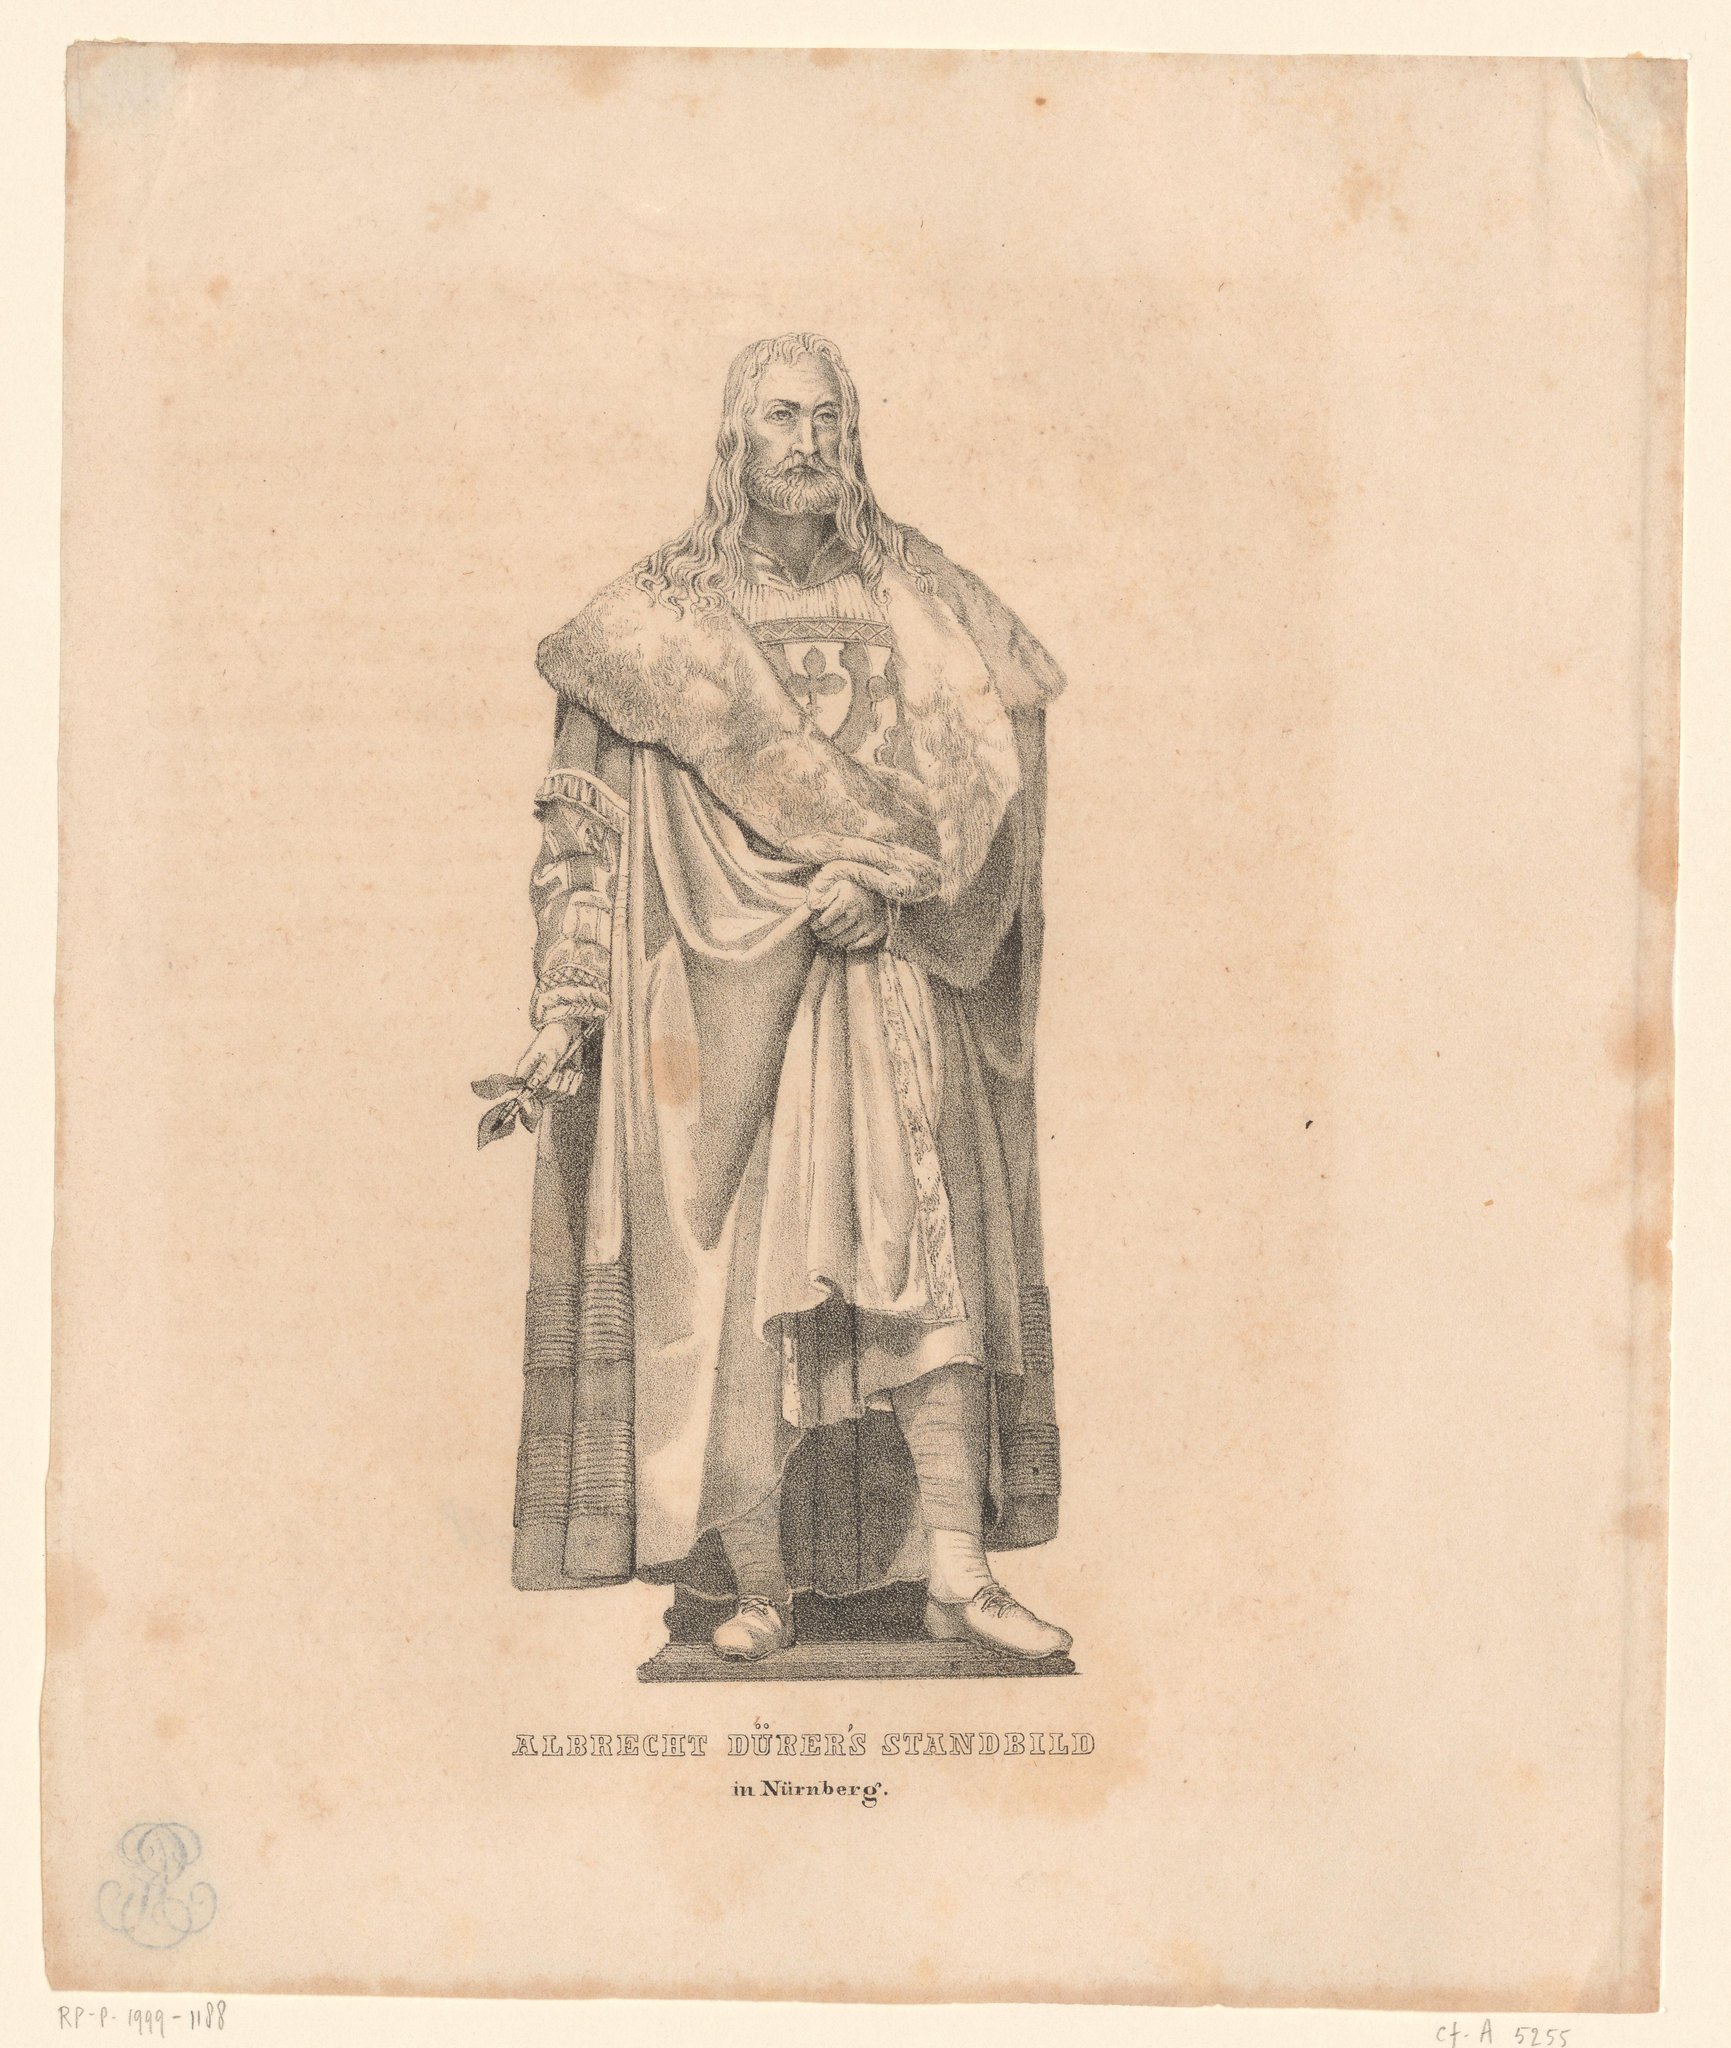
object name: print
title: Portret van Albrecht Dürer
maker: Anonymous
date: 1840-1899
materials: paper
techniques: lithograph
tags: painter, draughtsman, albrecht dürer, historical persons, portrait, self-portrait of painter, sculpture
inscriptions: collector's mark: Lugt 2228, collector's mark: Lugt 4100, collector's mark: Lugt 2760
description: Staand met schildergereedschap in zijn rechterhand, naar het monument voor Dürer in Neurenberg.